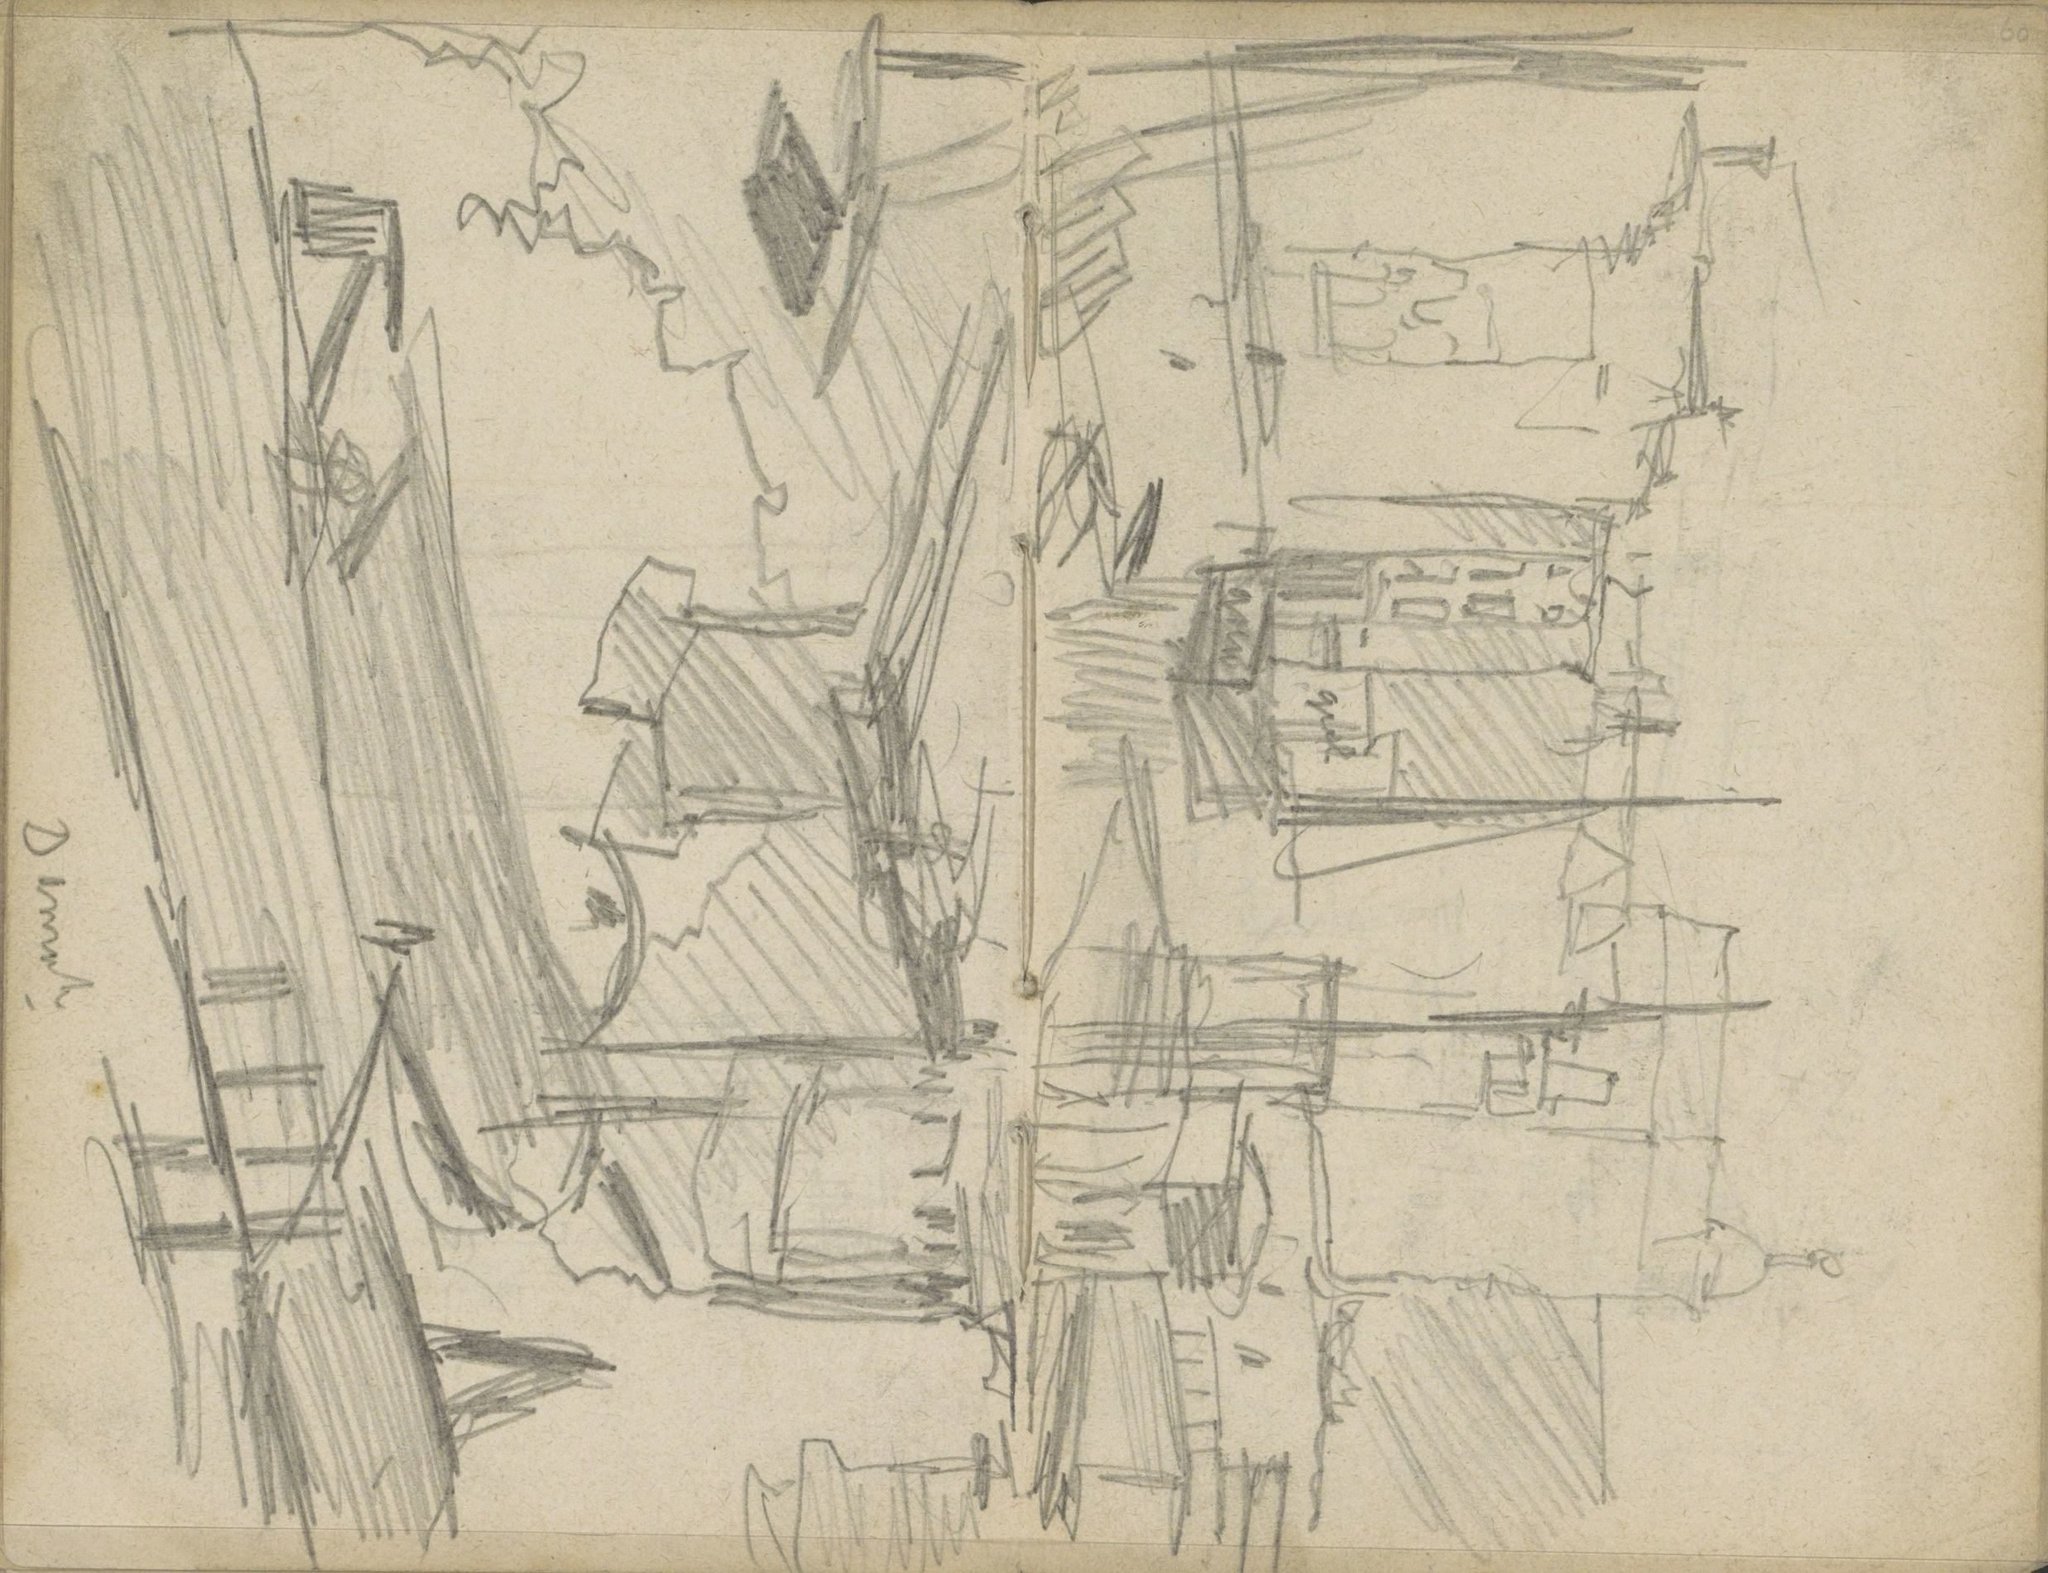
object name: sketchbook leaf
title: Gezicht op het Damrak te Amsterdam vanuit Warmoesstraat 56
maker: george hendrik breitner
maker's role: draughtsman, painter, print maker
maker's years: 1857-1923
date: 1903-1904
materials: paper, pencil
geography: amsterdam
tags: urban housing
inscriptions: annotation: ‘Damrak’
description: Gezicht op het Damrak te Amsterdam vanuit Warmoesstraat 56. Pagina 59 en pagina 60 uit een schetsboek met 46 bladen vervaardigd te Amsterdam.